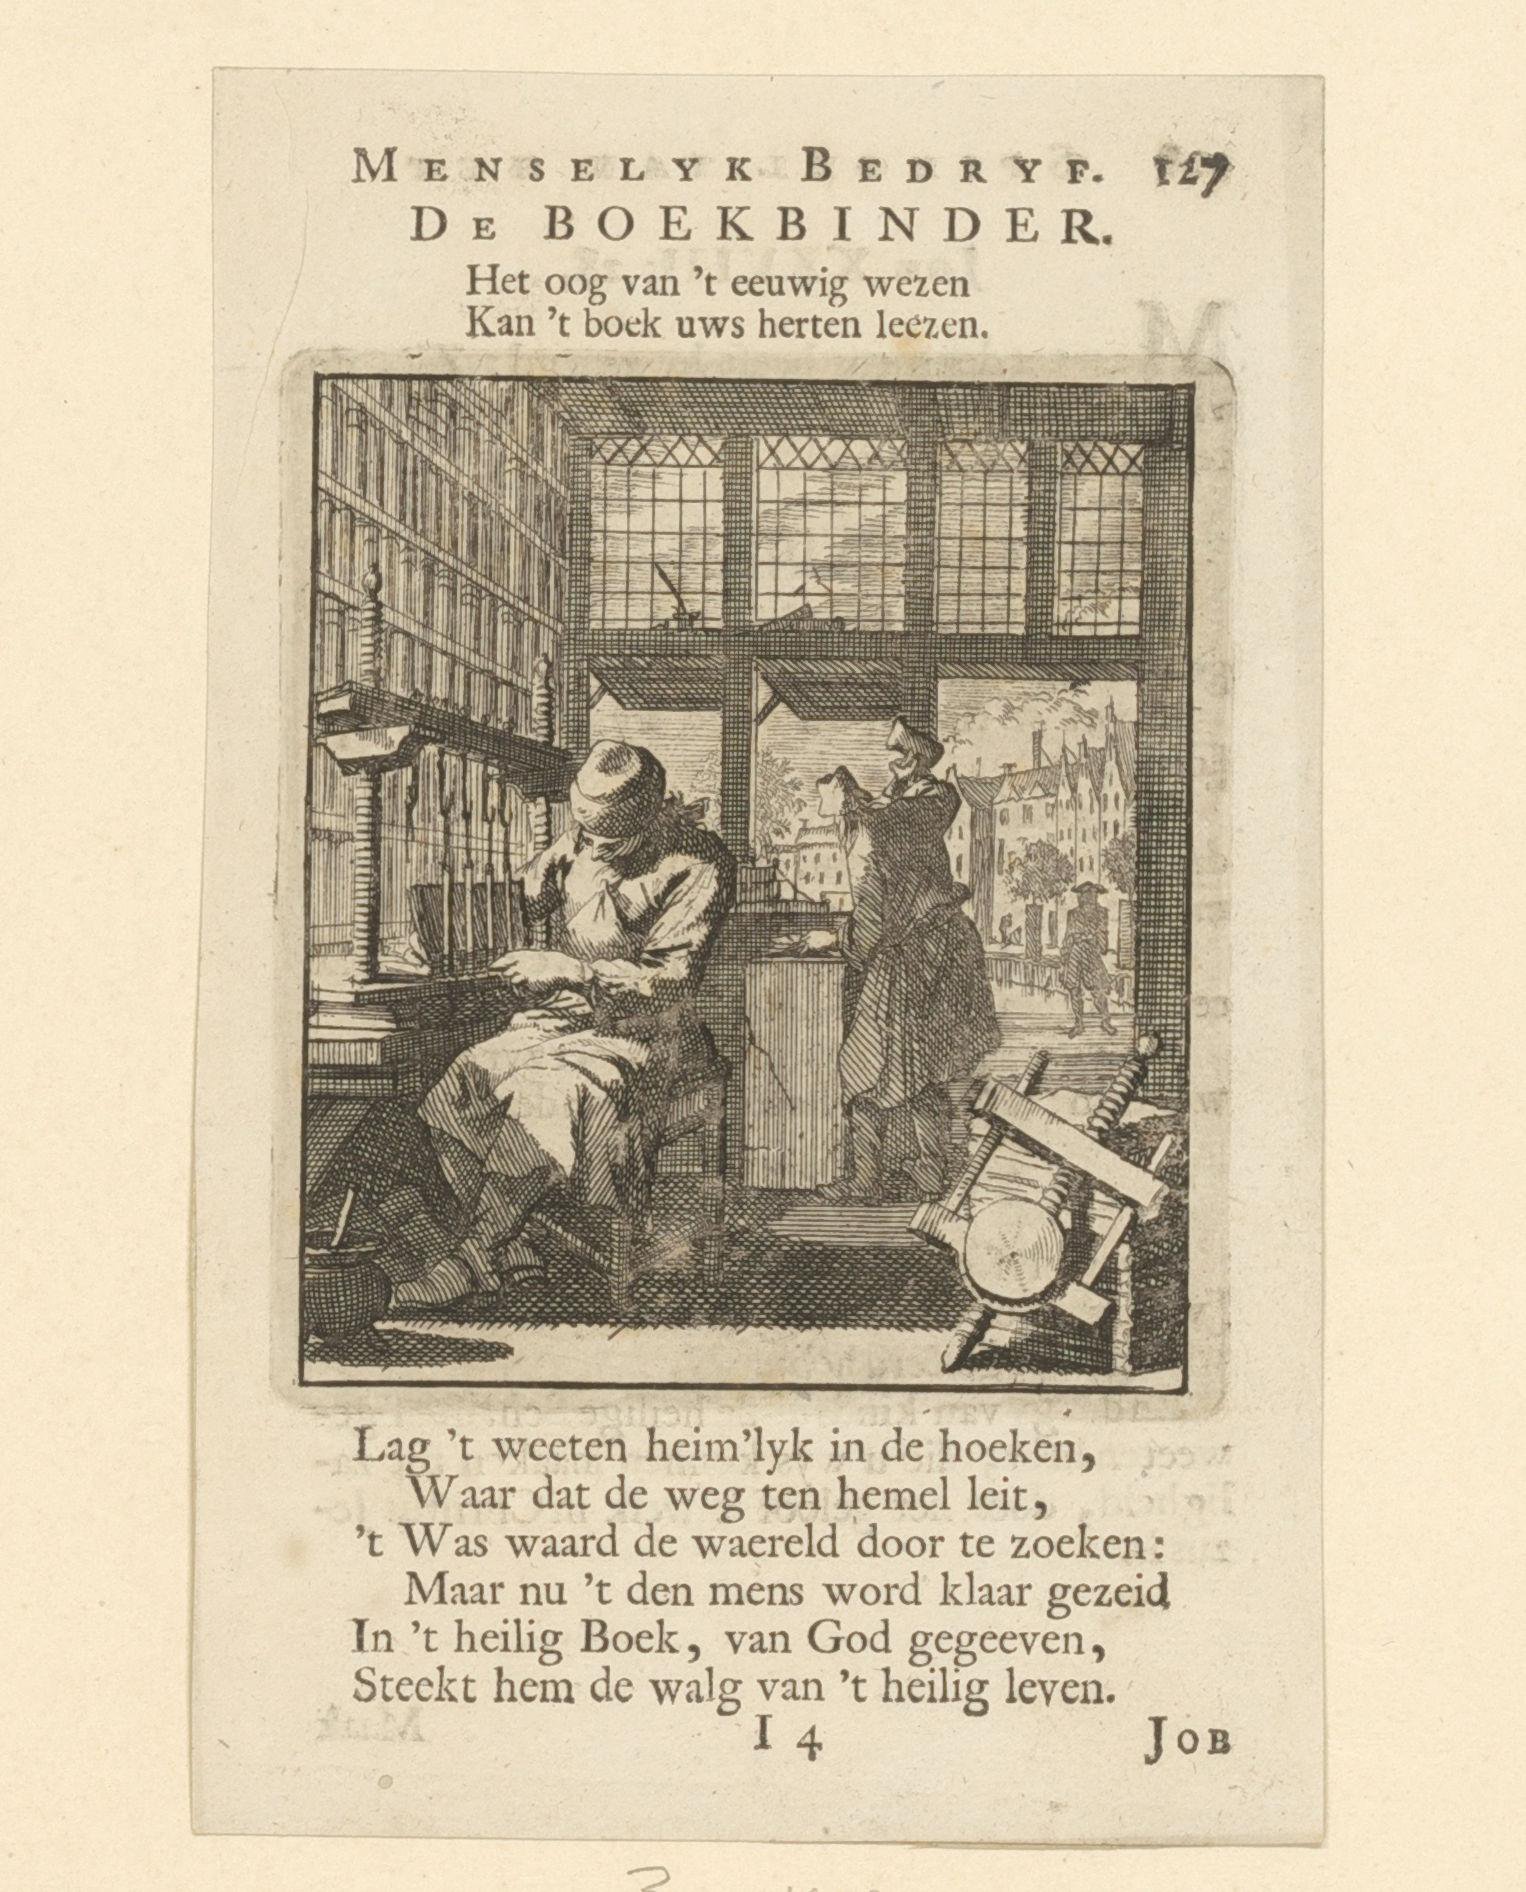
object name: print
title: De Boekdrukker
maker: cornelis van der sys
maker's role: publisher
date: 1718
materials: paper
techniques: etching, letterpress printing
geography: amsterdam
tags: bookbinding, handicrafts, craftsman at work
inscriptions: collector's mark: Lugt 1641, stamp, stamp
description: Prent oorspronkelijk verschenen in de 100-delige serie beroepsprenten van Jan en Caspar Luyken, getiteld: Het menselyk bedryf. S.l.s.n., 1694 (eerste druk). Daarna is de titel en het vers afgesneden. De prenten in diverse publicaties verschenen en gekopieerd. Huidige staat uit: Luyken, Jan en Caspar. Spiegel van het menselyk bedryf (...). Amsterdam: Cornelis van der Sys, 1718, p. 129. Prent waarschijnlijk ook gebruikt in eerdere (1704) en latere (1730, 1749, 1767) publicaties.